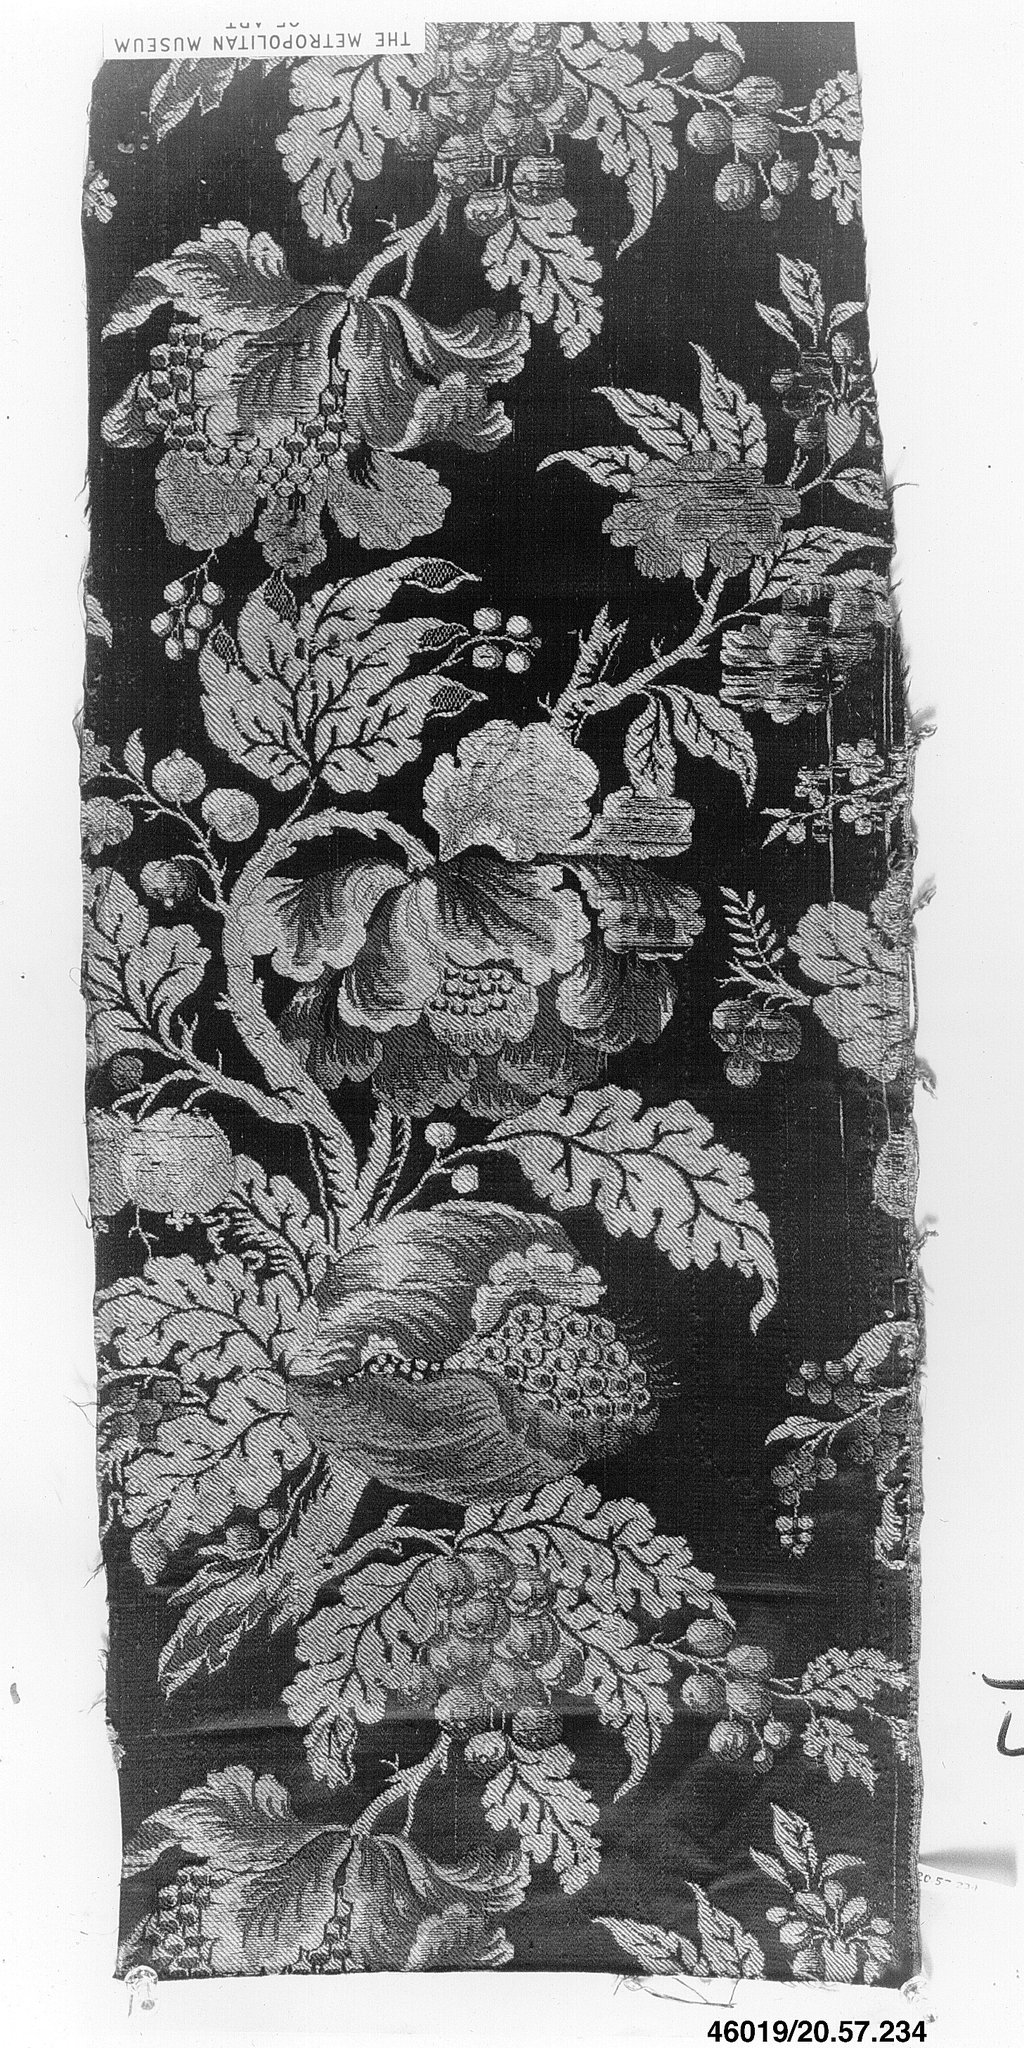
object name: piece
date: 1735-1740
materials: silk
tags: grapes,flowers,leaves